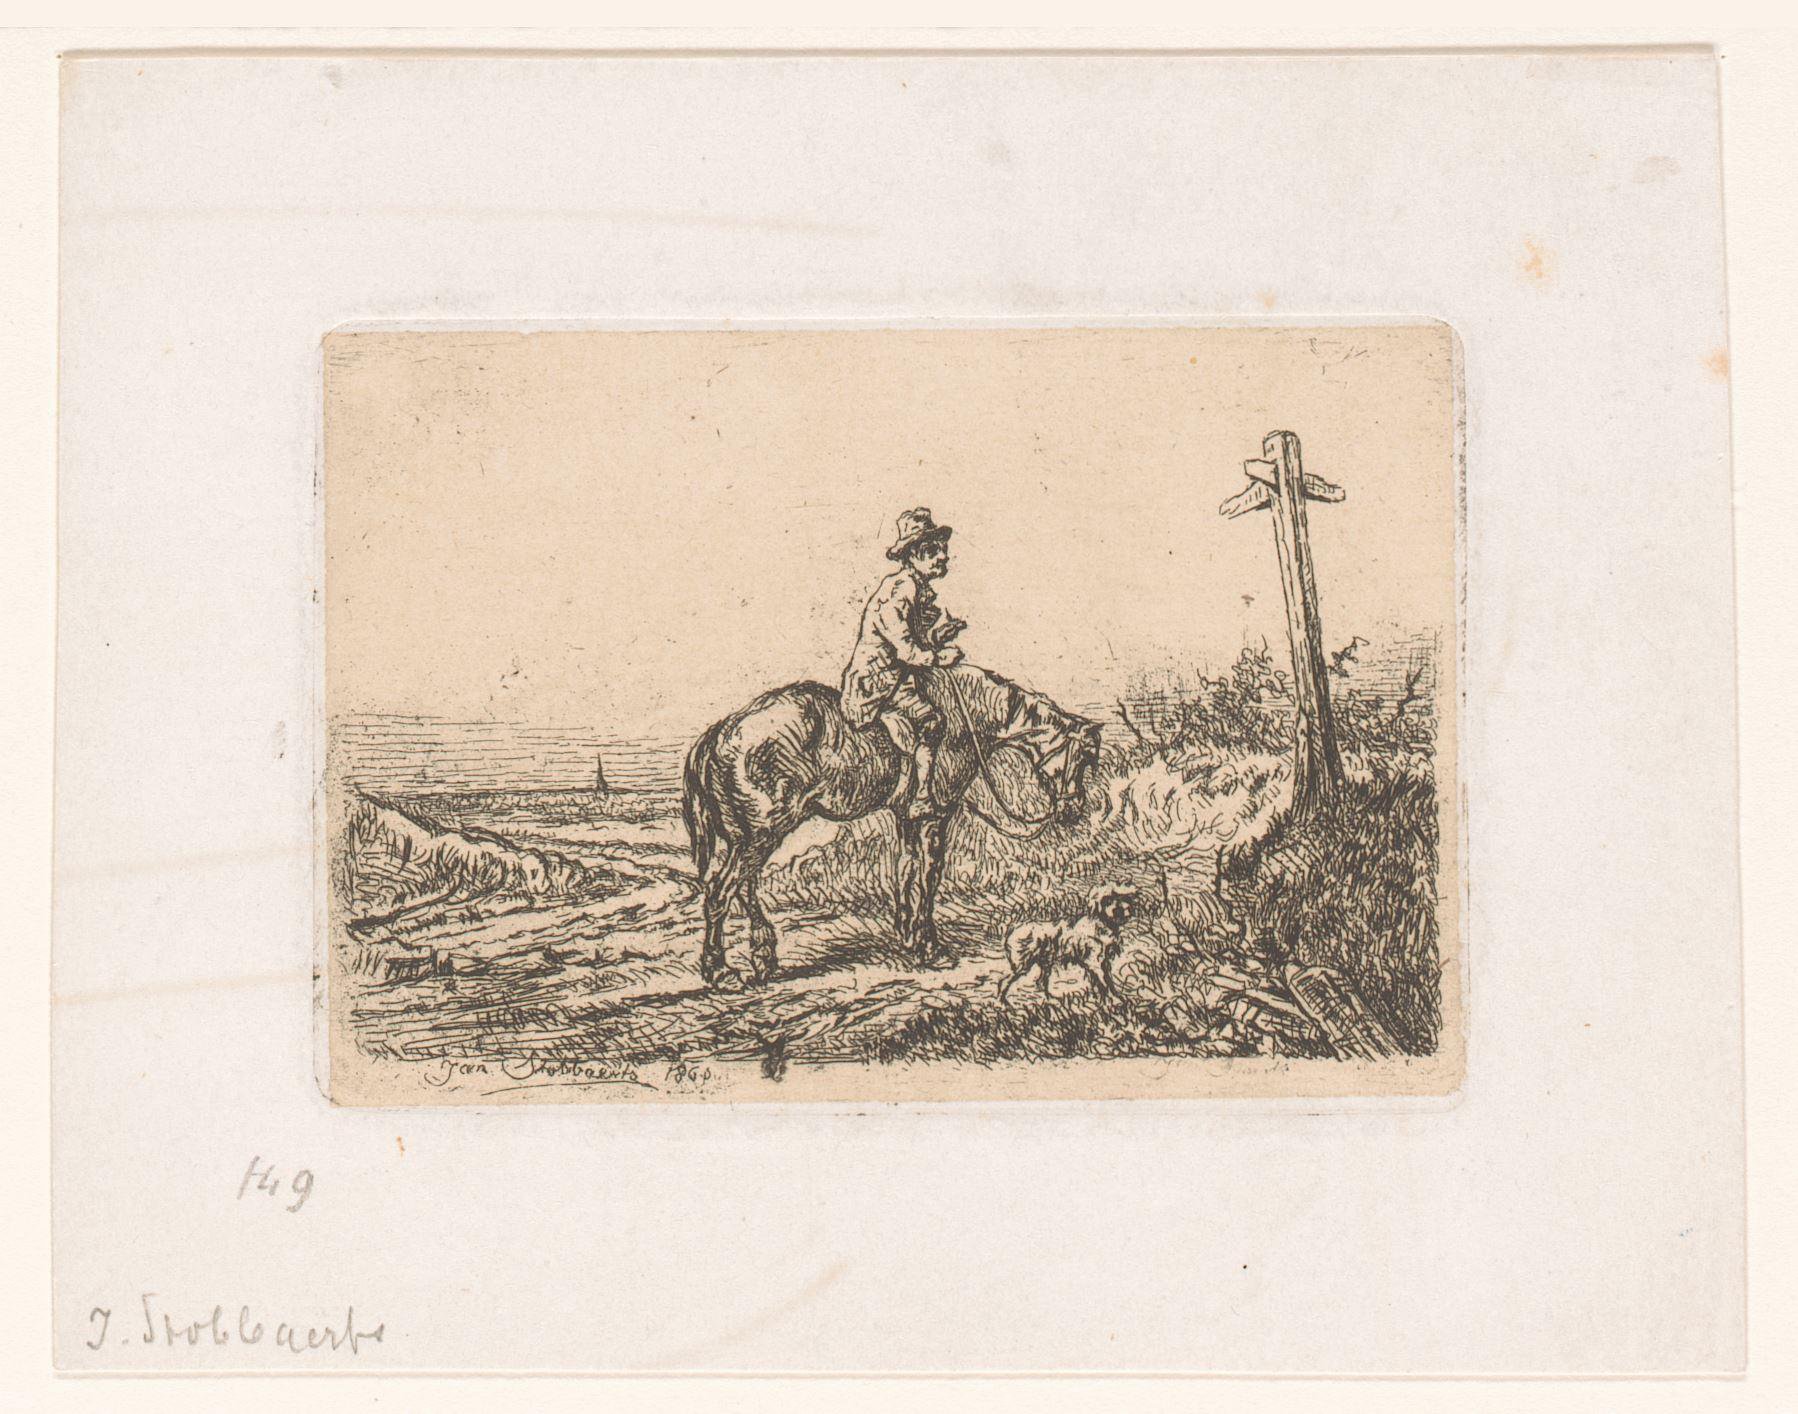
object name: print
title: Ruiter te paard bij een wegwijzerbord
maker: jan stobbaerts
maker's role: draughtsman, print maker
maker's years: 1838-1914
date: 1860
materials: paper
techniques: etching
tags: riding a horse, ass, or mule; rider, horseman, signpost, dog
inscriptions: collector's mark: Lugt 2228